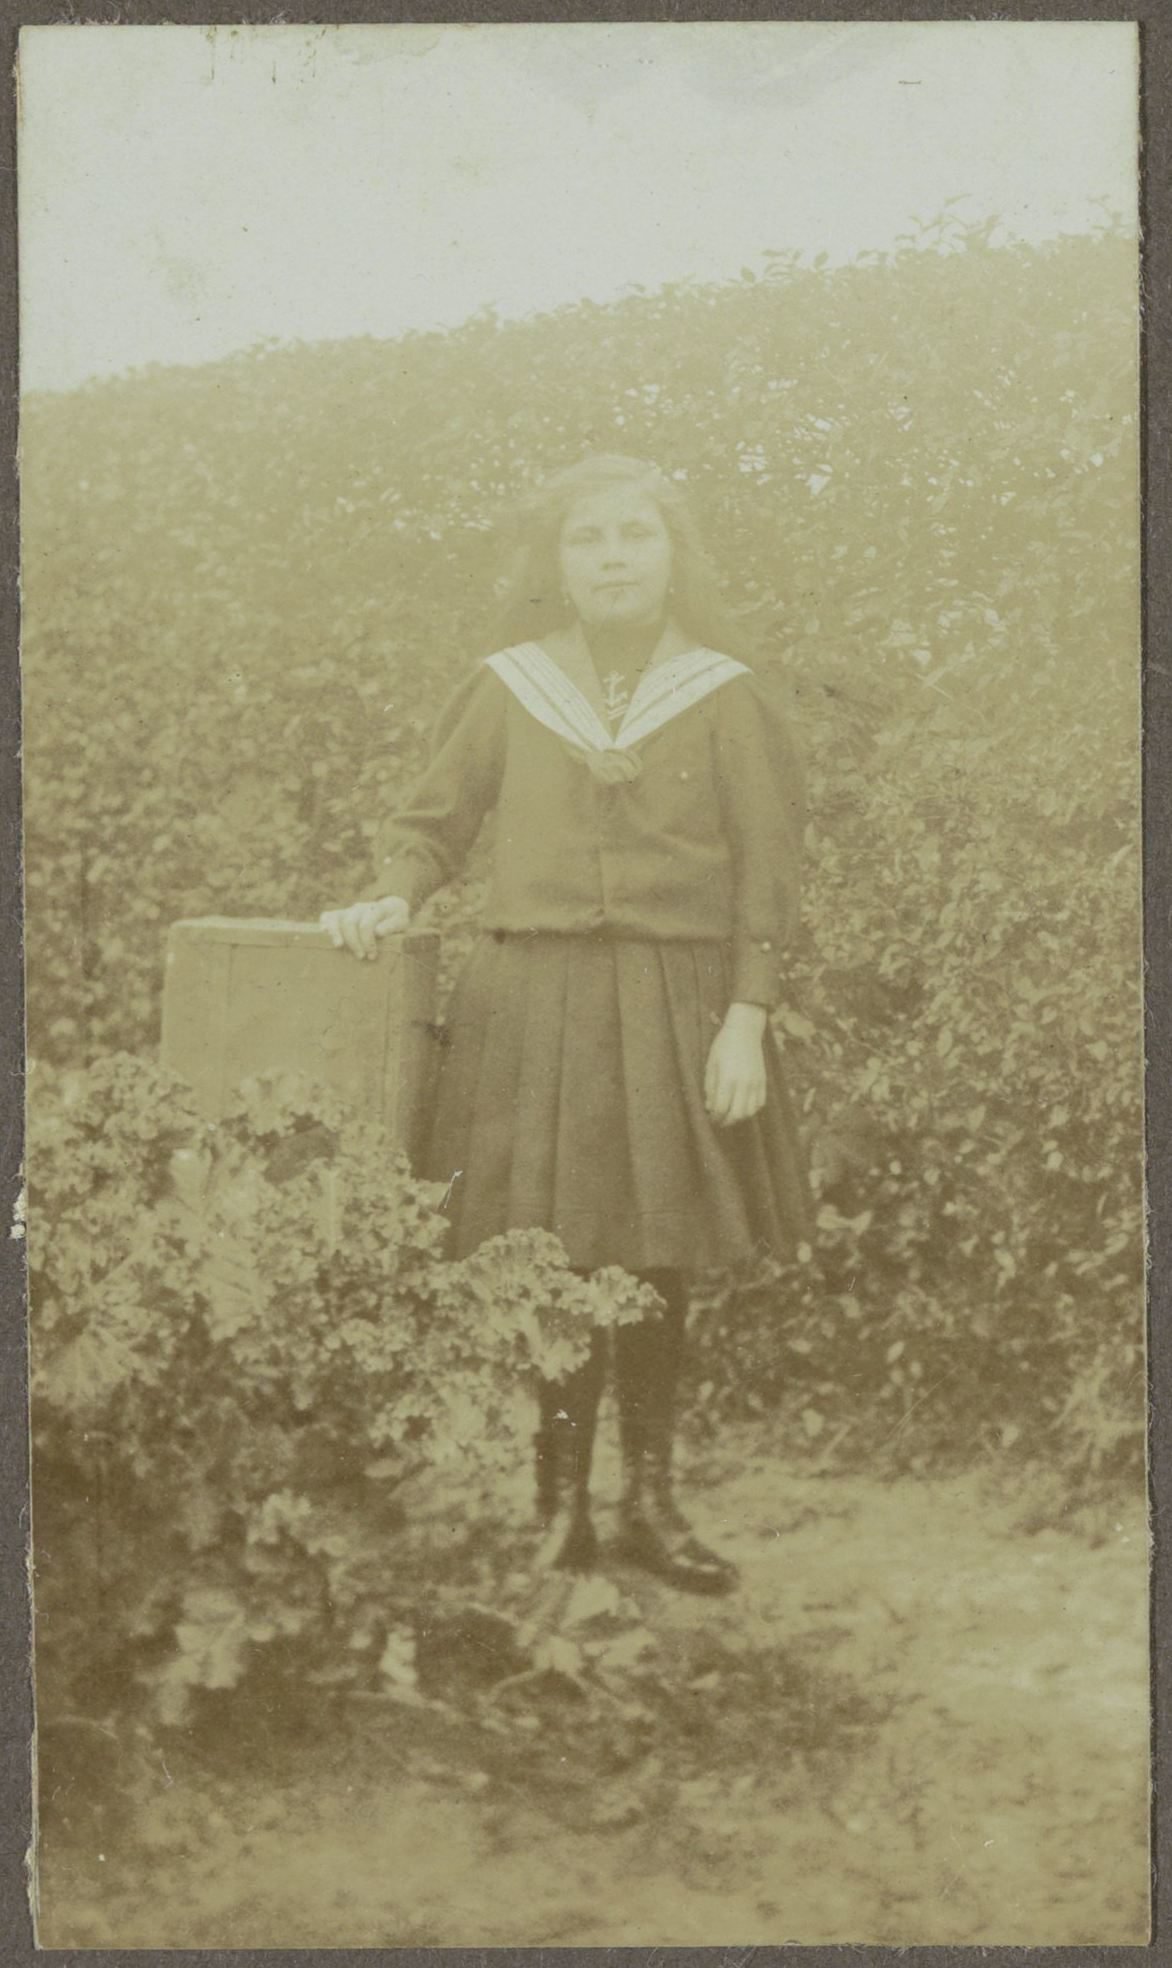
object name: photograph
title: Portret van een jong meisje in een jurk, staand tussen struiken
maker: Anonymous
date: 1920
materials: cardboard, paper, photographic support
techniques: gelatin silver print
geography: netherlands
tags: shrubs, child, historical persons, dress, gown, netherlands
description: Onderdeel van Fotoalbum met portretten vervaardigd door Nederlandse studio's waaronder automaatfoto's.